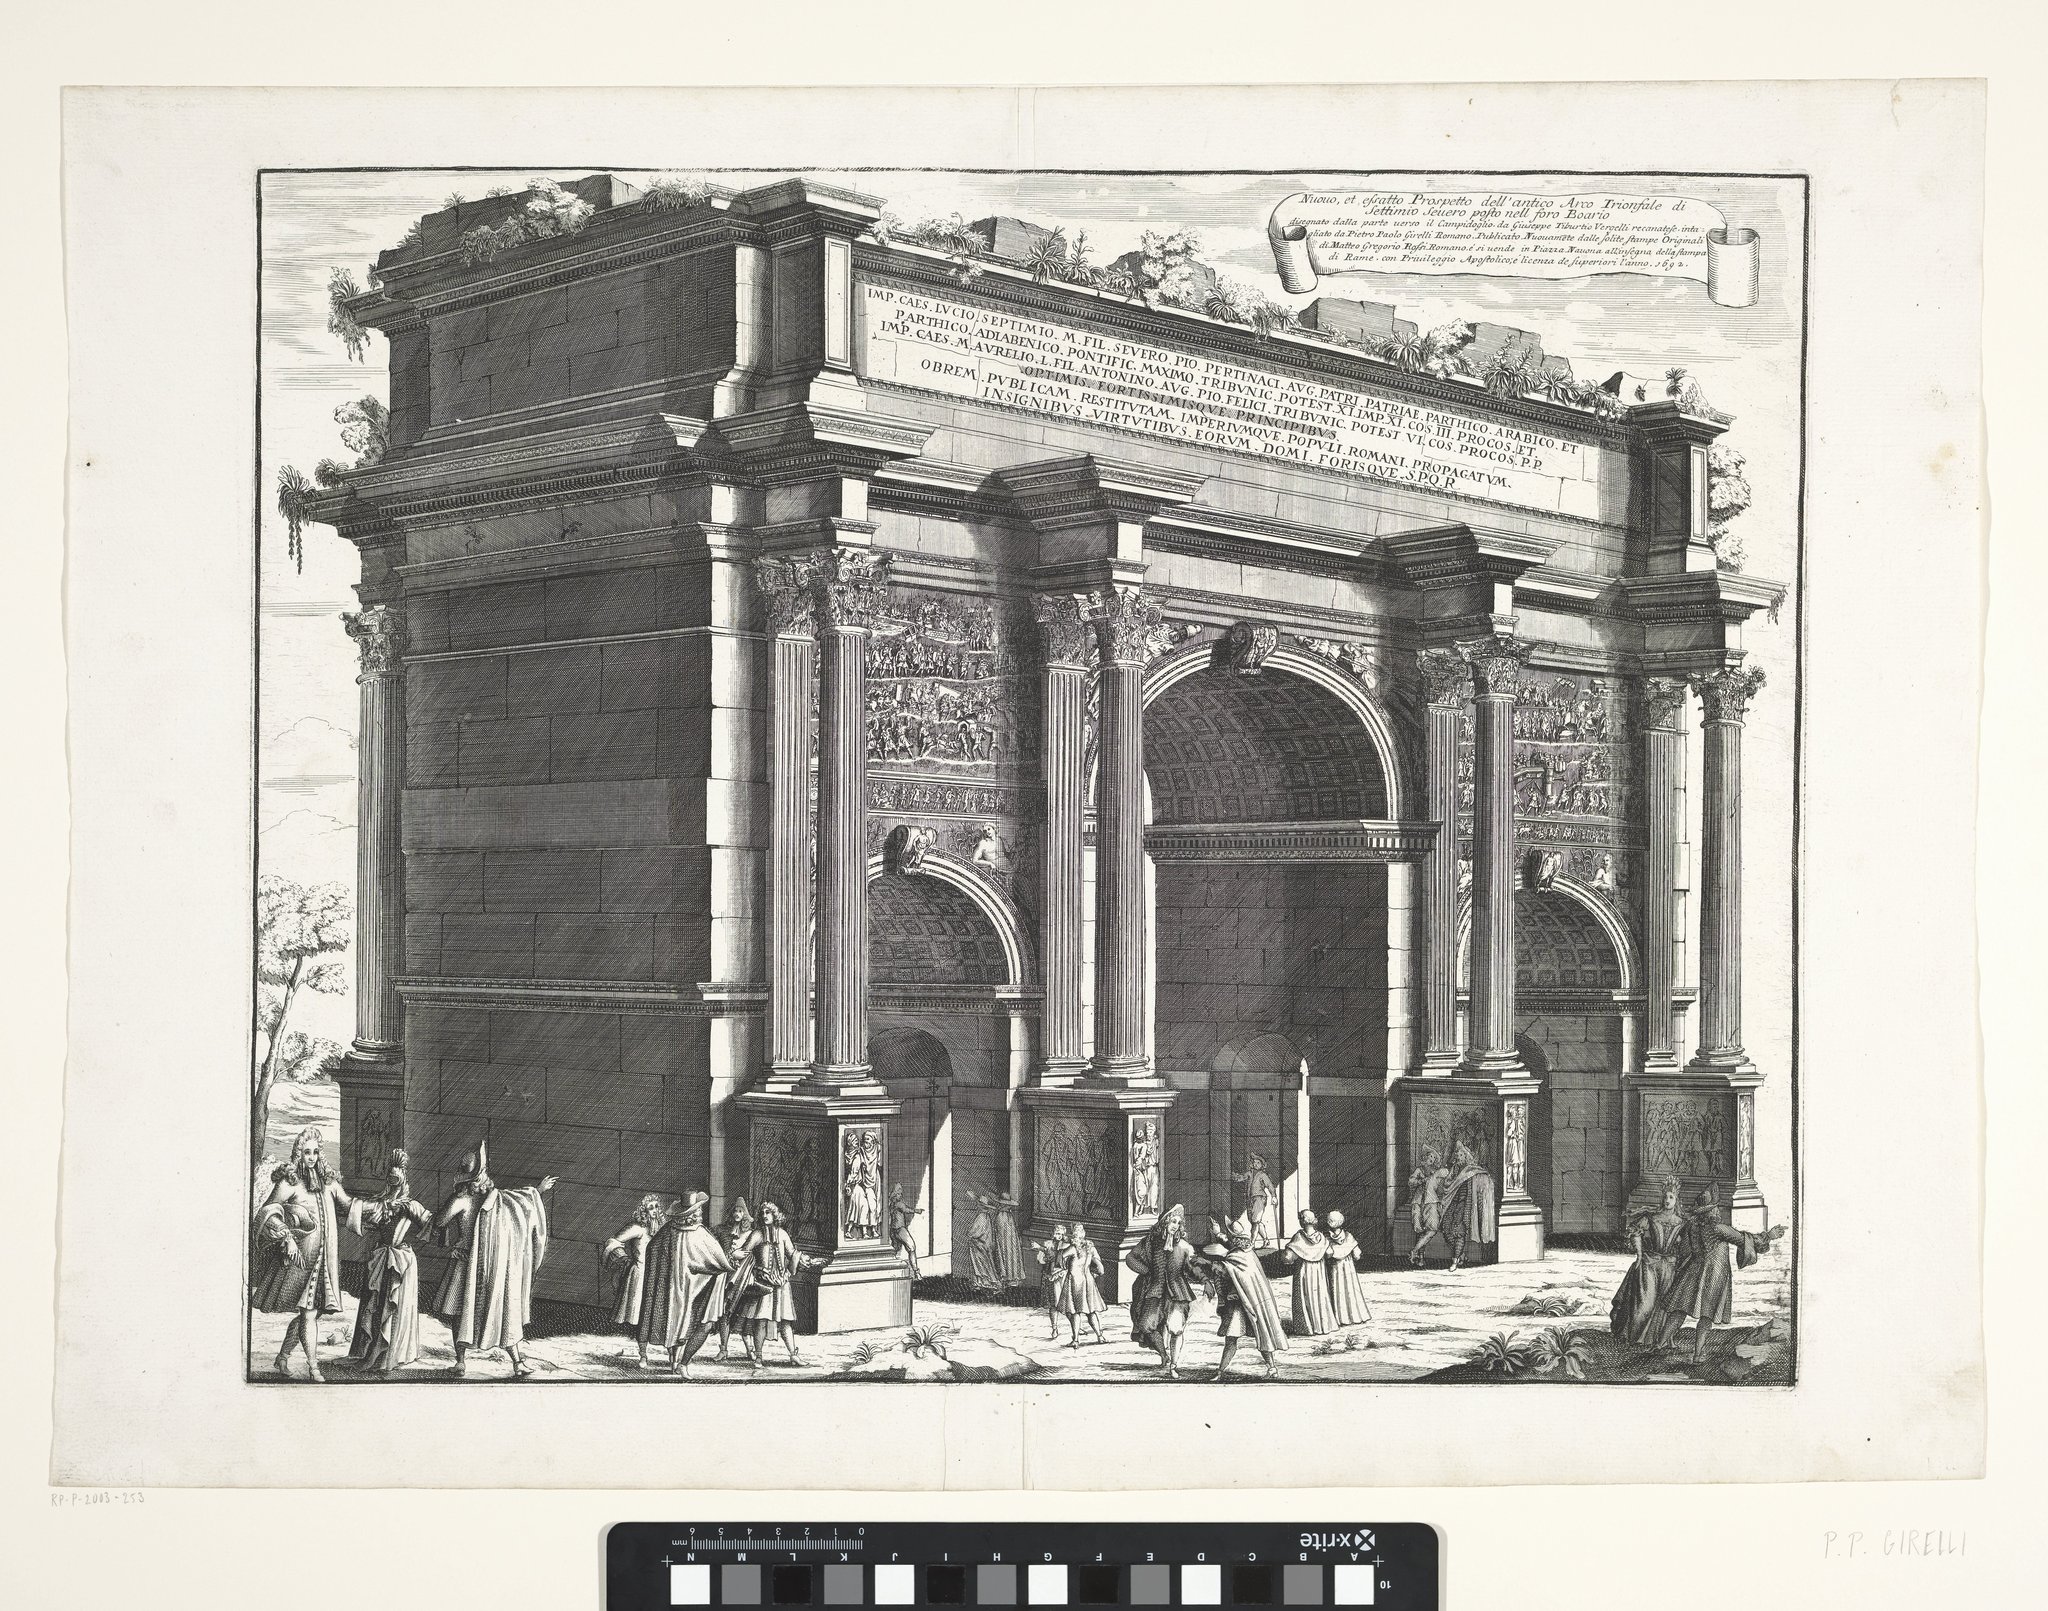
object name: print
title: Nuovo, et essatto Prospetto dell'antico Arco Trionfale di Settimo Severo posto nell foro Boario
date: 1692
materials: paper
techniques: engraving, etching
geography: vatican city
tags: triumphal arch, rome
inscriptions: collector's mark: Lugt 2760, collector's mark: Lugt 2228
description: Gezicht op de Boog van Septimius Severus op het Forum Romanum te Rome. Rechtsboven een banderol met tekst.